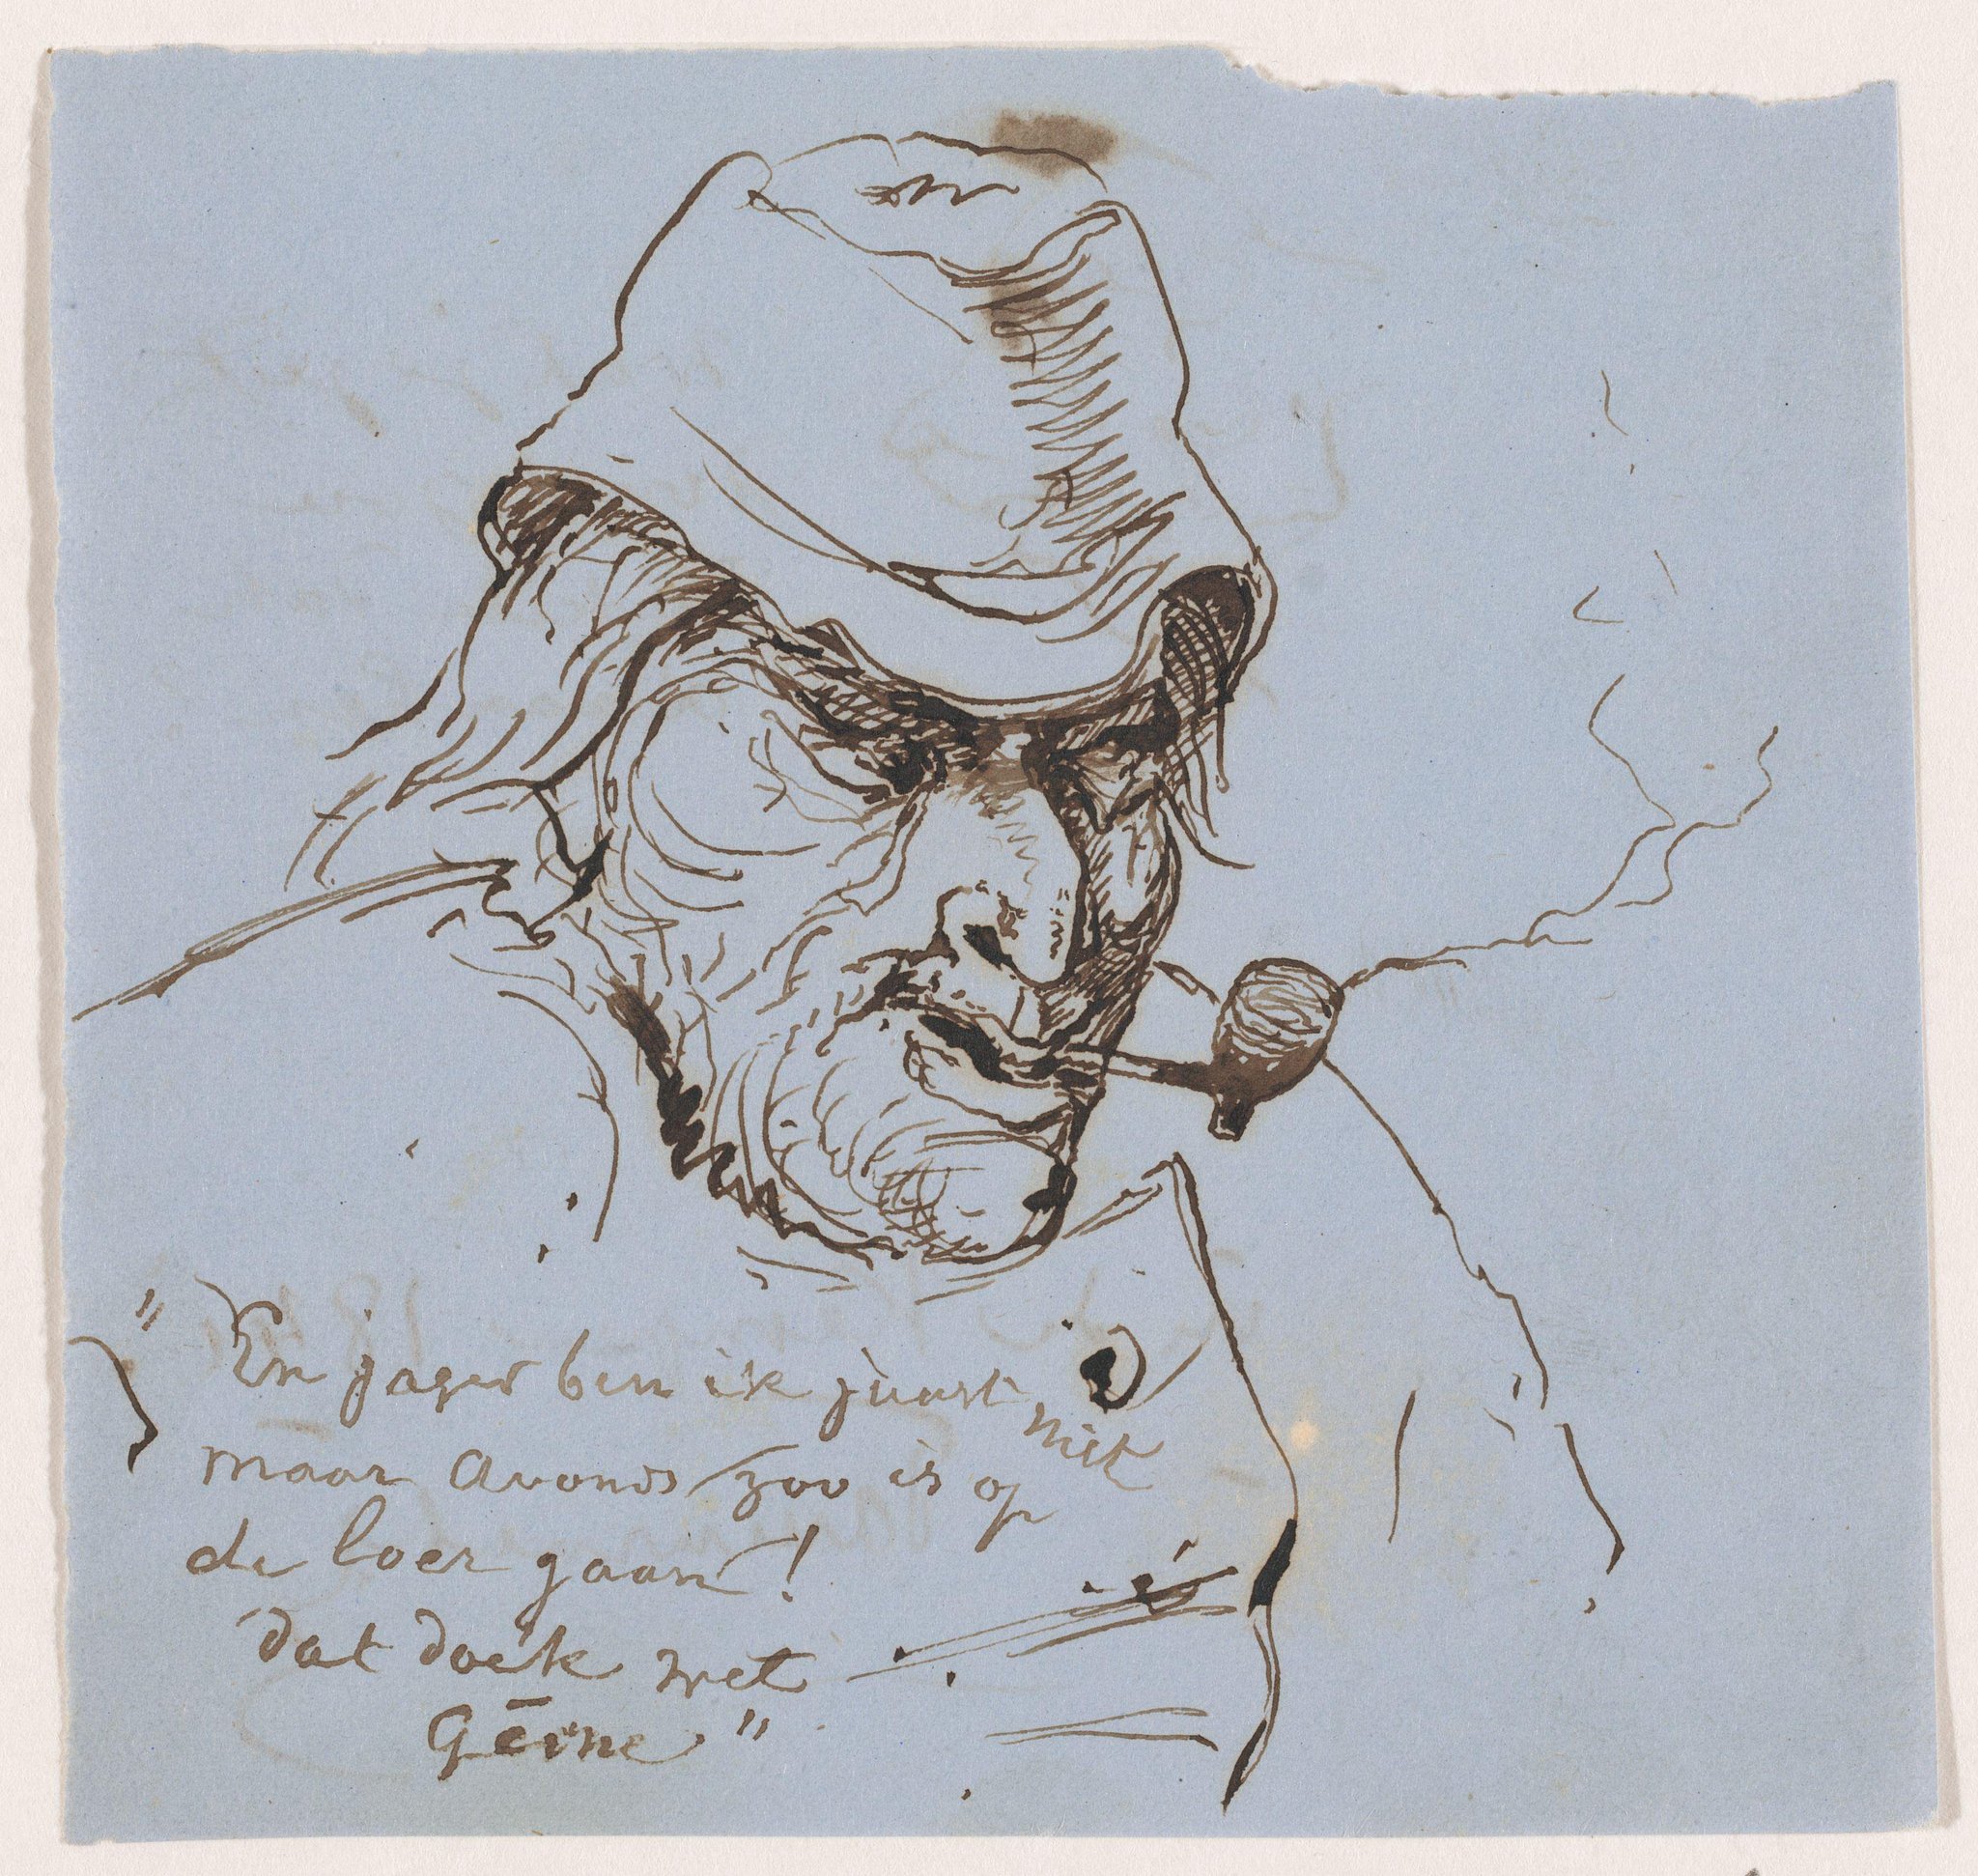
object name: drawing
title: Man met pijp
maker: johannes tavenraat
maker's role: draughtsman, painter, print maker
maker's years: 1809-1881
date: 1841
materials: ink, paper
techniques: pen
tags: hunter, pipe ~ tobacco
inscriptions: collector's mark: Lugt 2228, annotation: ‘"Een jager ben ik juist niet ...’, signature, date and inscription: ‘in de Kempen 1841. Tavenraat’